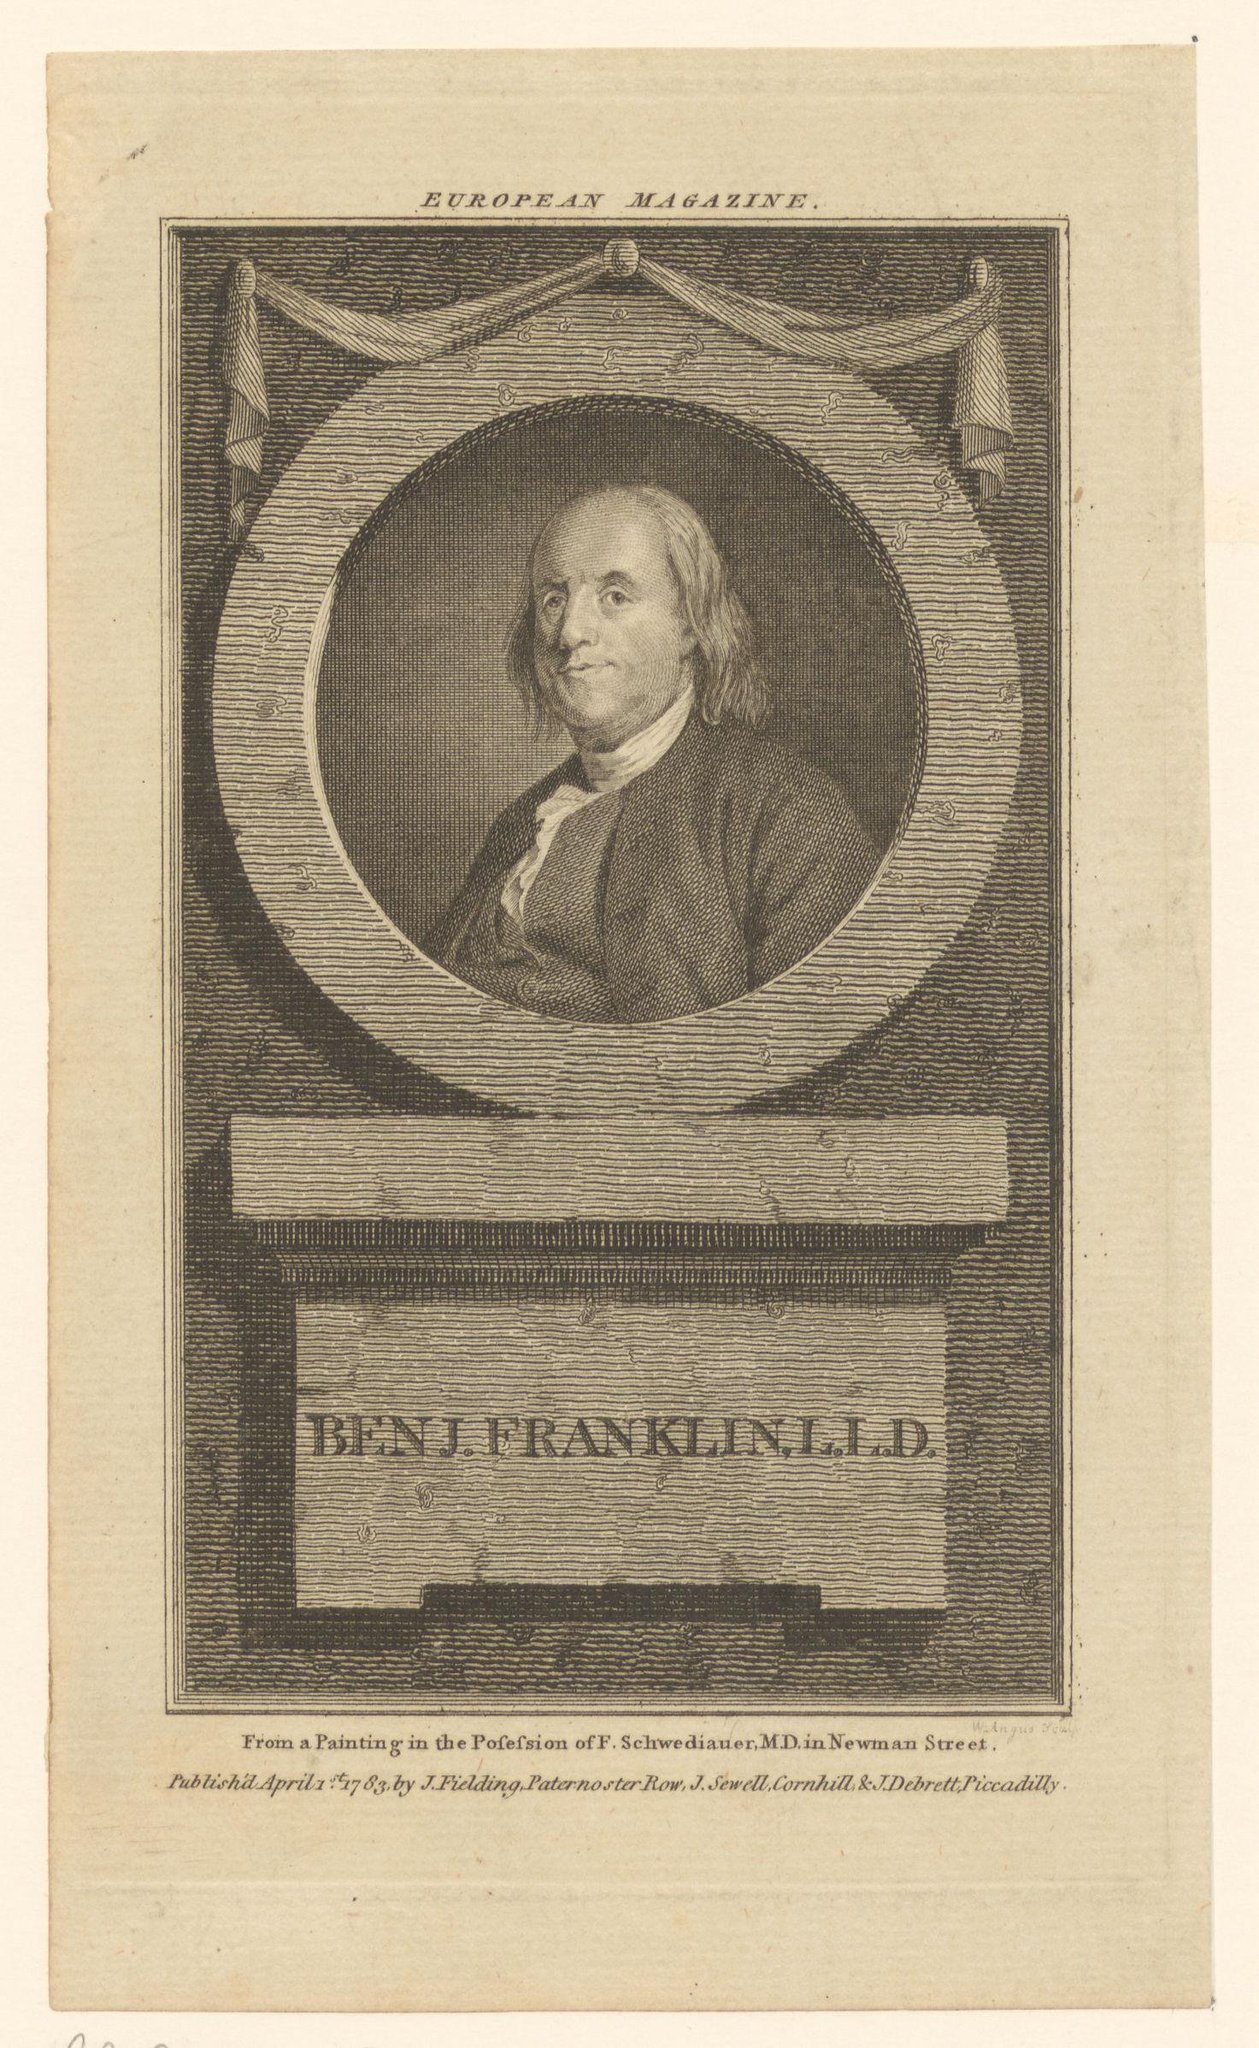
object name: print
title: Portret van Benjamin Franklin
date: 1783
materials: paper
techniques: etching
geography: london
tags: physicist, historical persons, politician, e.g. party leader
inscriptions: collector's mark: Lugt 2228, collector's mark: Lugt 2760